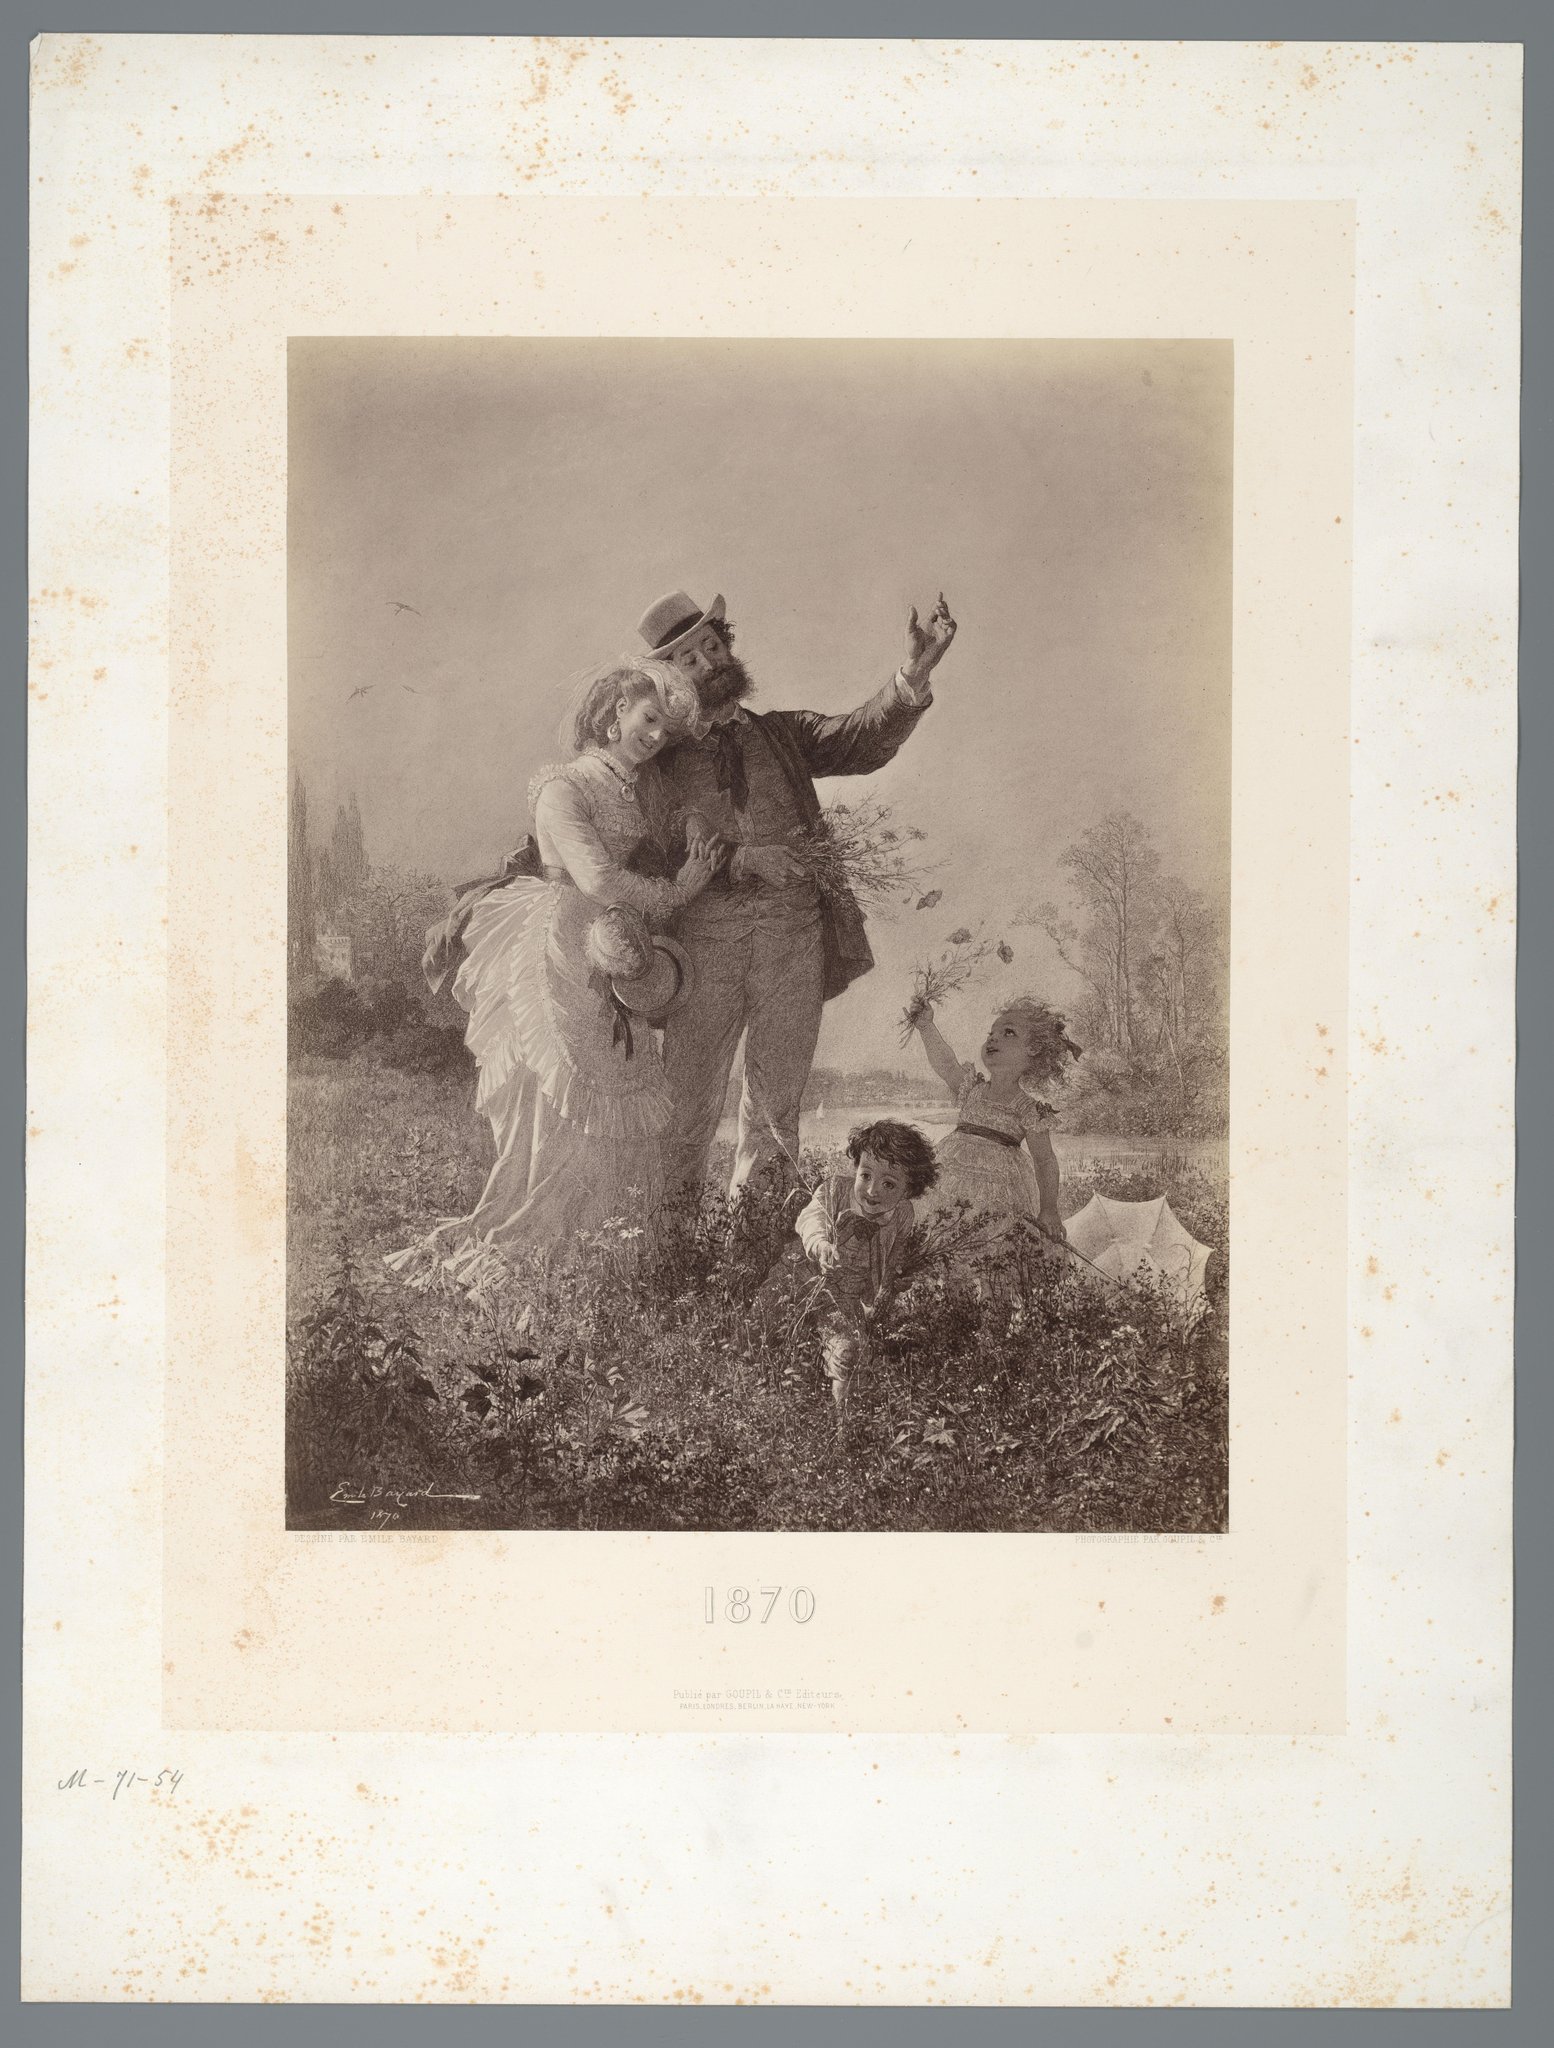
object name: photograph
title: Fotoreproductie van een tekening van een familie in een veld met bloemen door Émile-Antoine Bayard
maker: émile-antoine bayard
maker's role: draughtsman, painter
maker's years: 1837-1891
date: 1870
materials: cardboard, paper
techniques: albumen print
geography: paris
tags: family group, especially parents with their child(ren)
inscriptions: inscription: ‘M-71-54’, date: ‘1870’